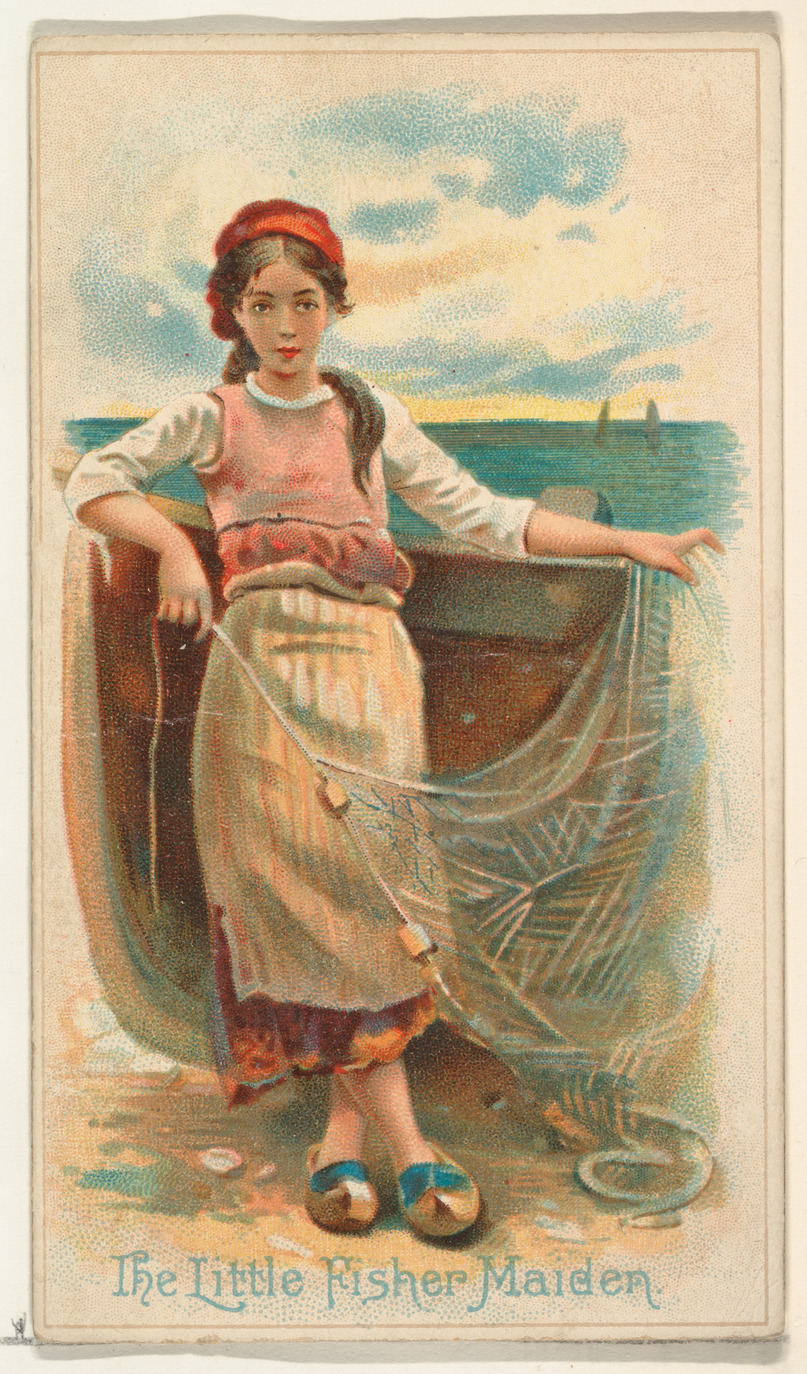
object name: print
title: The Little Fisher Maiden, from the Illustrated Songs series (N116) issued by W. Duke, Sons & Co. to promote Honest Long Cut Tobacco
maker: w. duke, sons & co.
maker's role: publisher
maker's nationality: american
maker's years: 1870-1920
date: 1893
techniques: color lithograph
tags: women